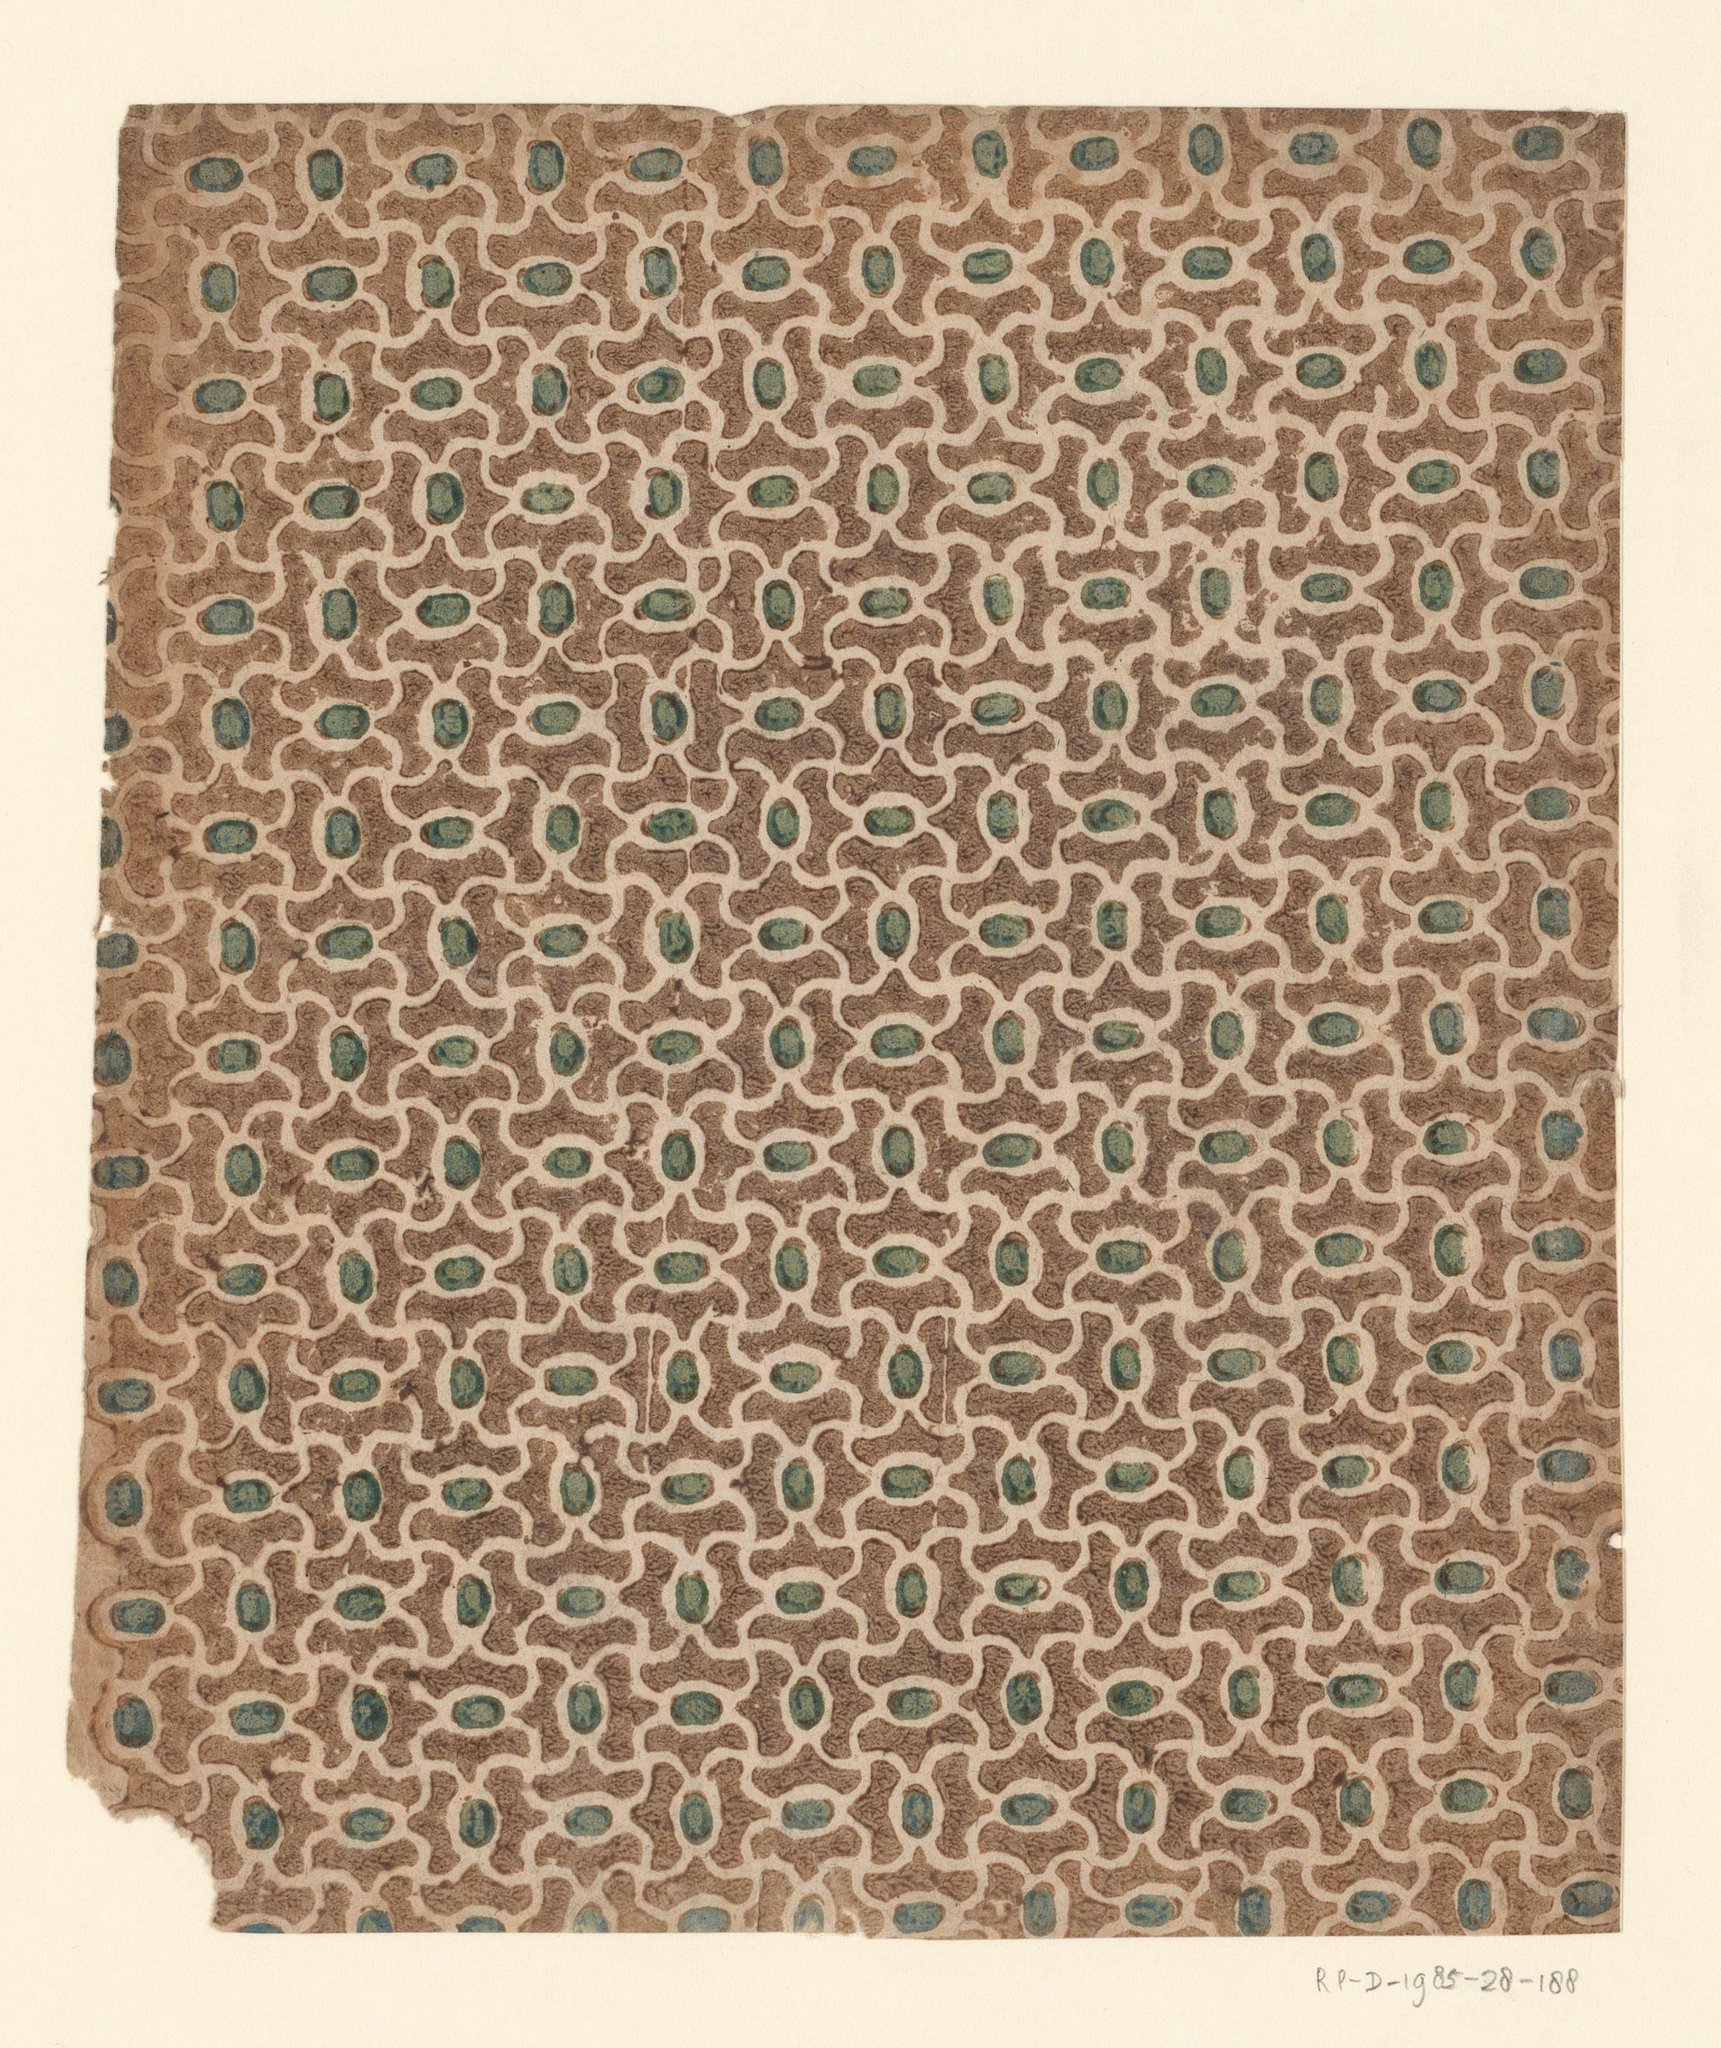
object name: wrapper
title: Blad met patroon van uitgespaarde kronkelende lijnen met ovaal motief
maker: Anonymous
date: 1750-1900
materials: paper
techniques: printing block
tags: fantasy ornament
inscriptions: collector's mark: Lugt 2760, collector's mark: Lugt 2228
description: Blad met patroon van uitgespaarde kronkelende lijnen met ovaal motief. Helft van een omslag.